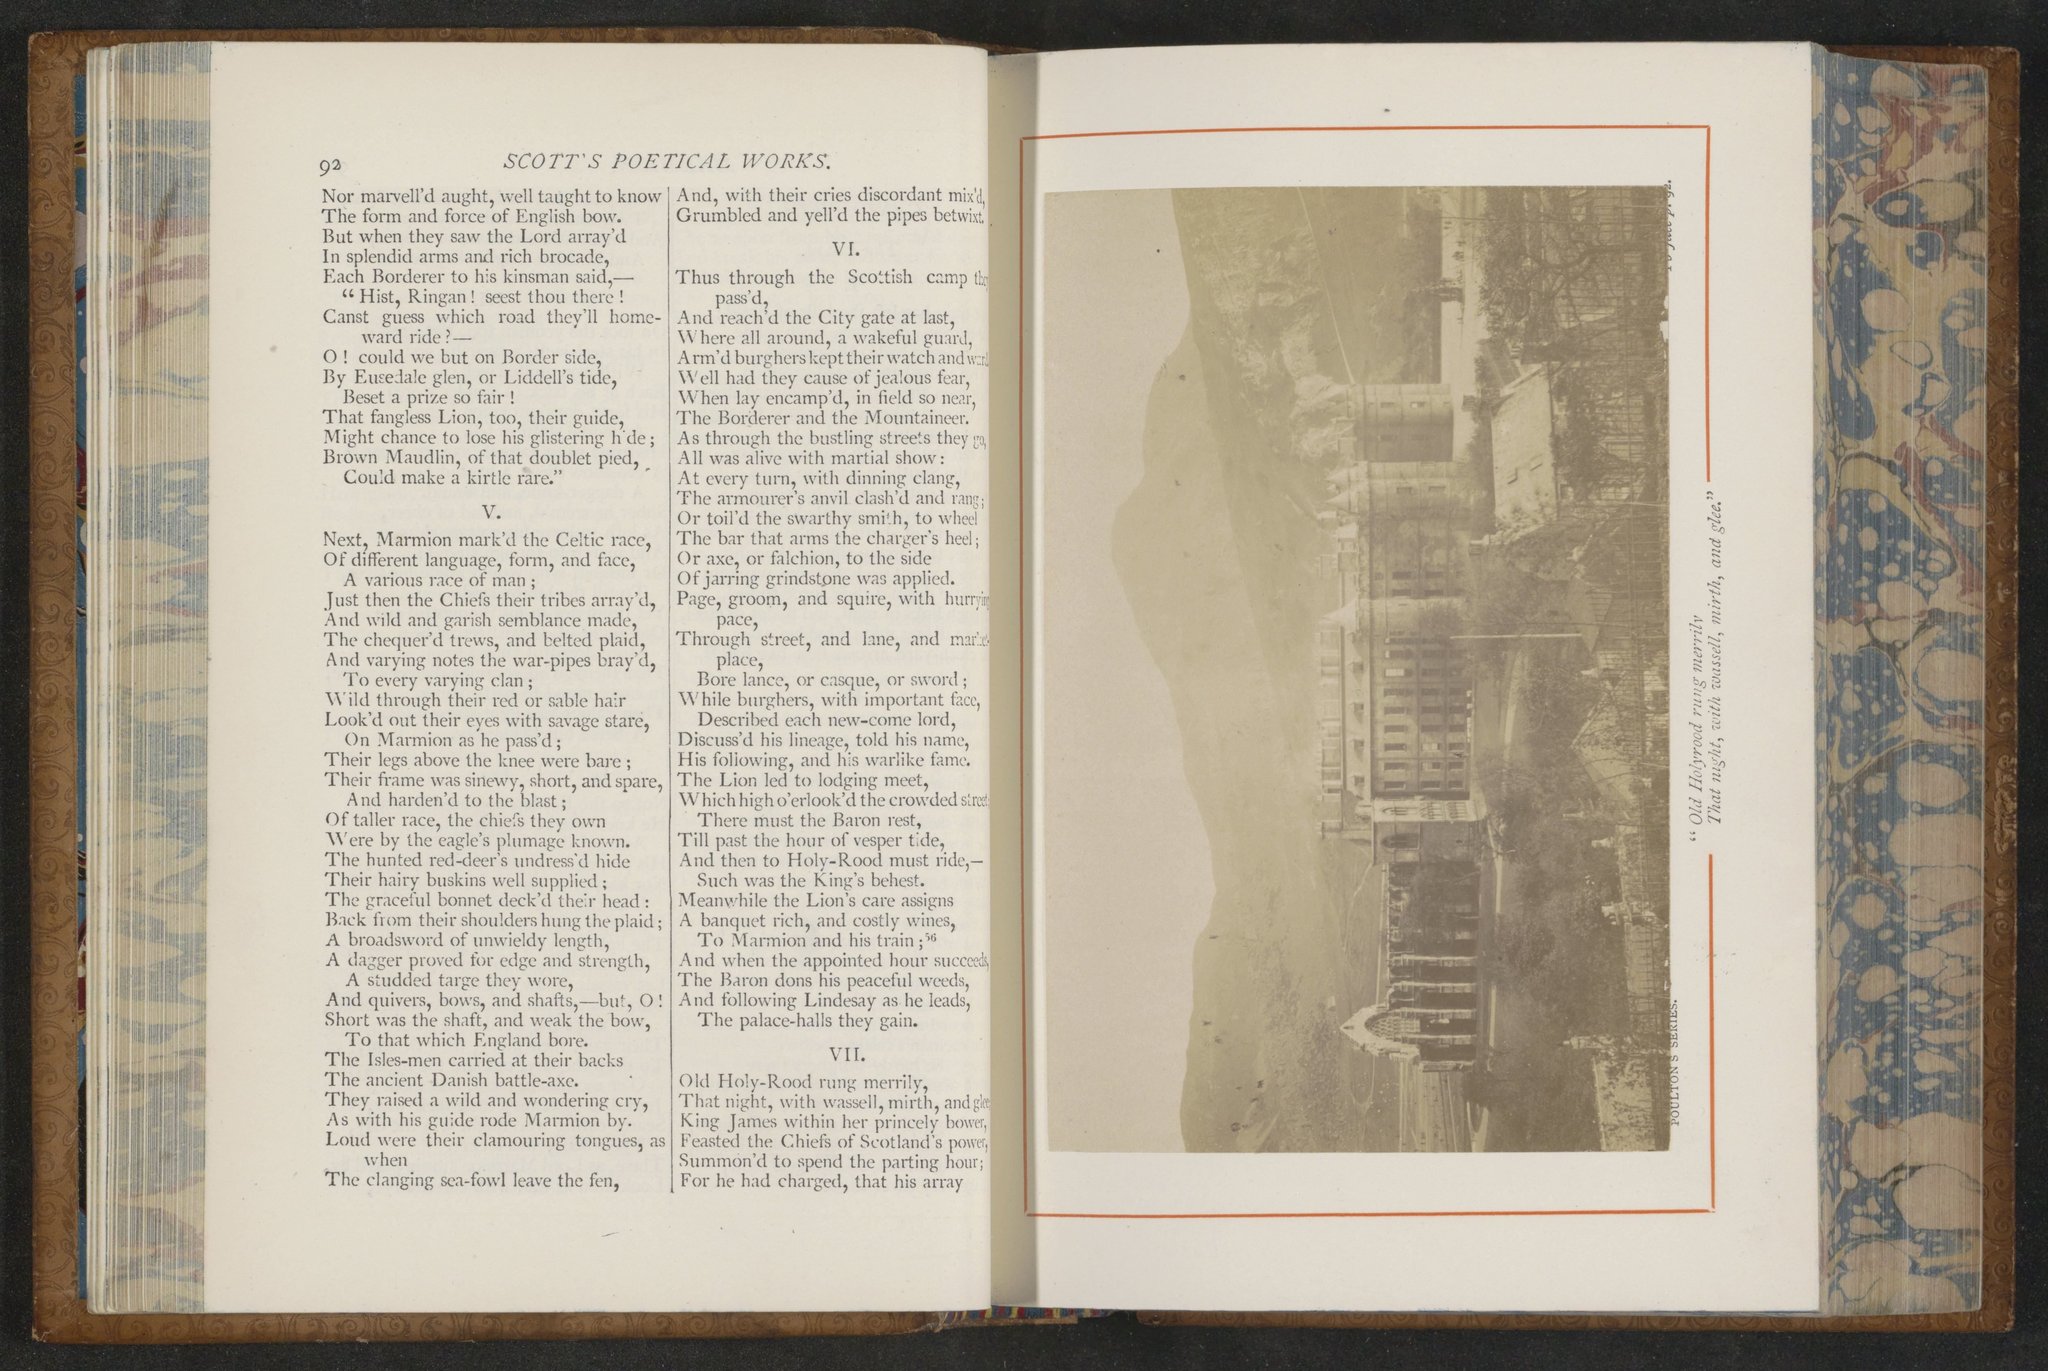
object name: page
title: Gezicht op het Palace of Holyroodhouse en de ruïne van de abdij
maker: Anonymous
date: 1880-1890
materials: photographic support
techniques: albumen print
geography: holyrood abbey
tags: ruin of church, monastery, etc., landscape with tower or castle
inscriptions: inscription: ‘Poulton's series.’